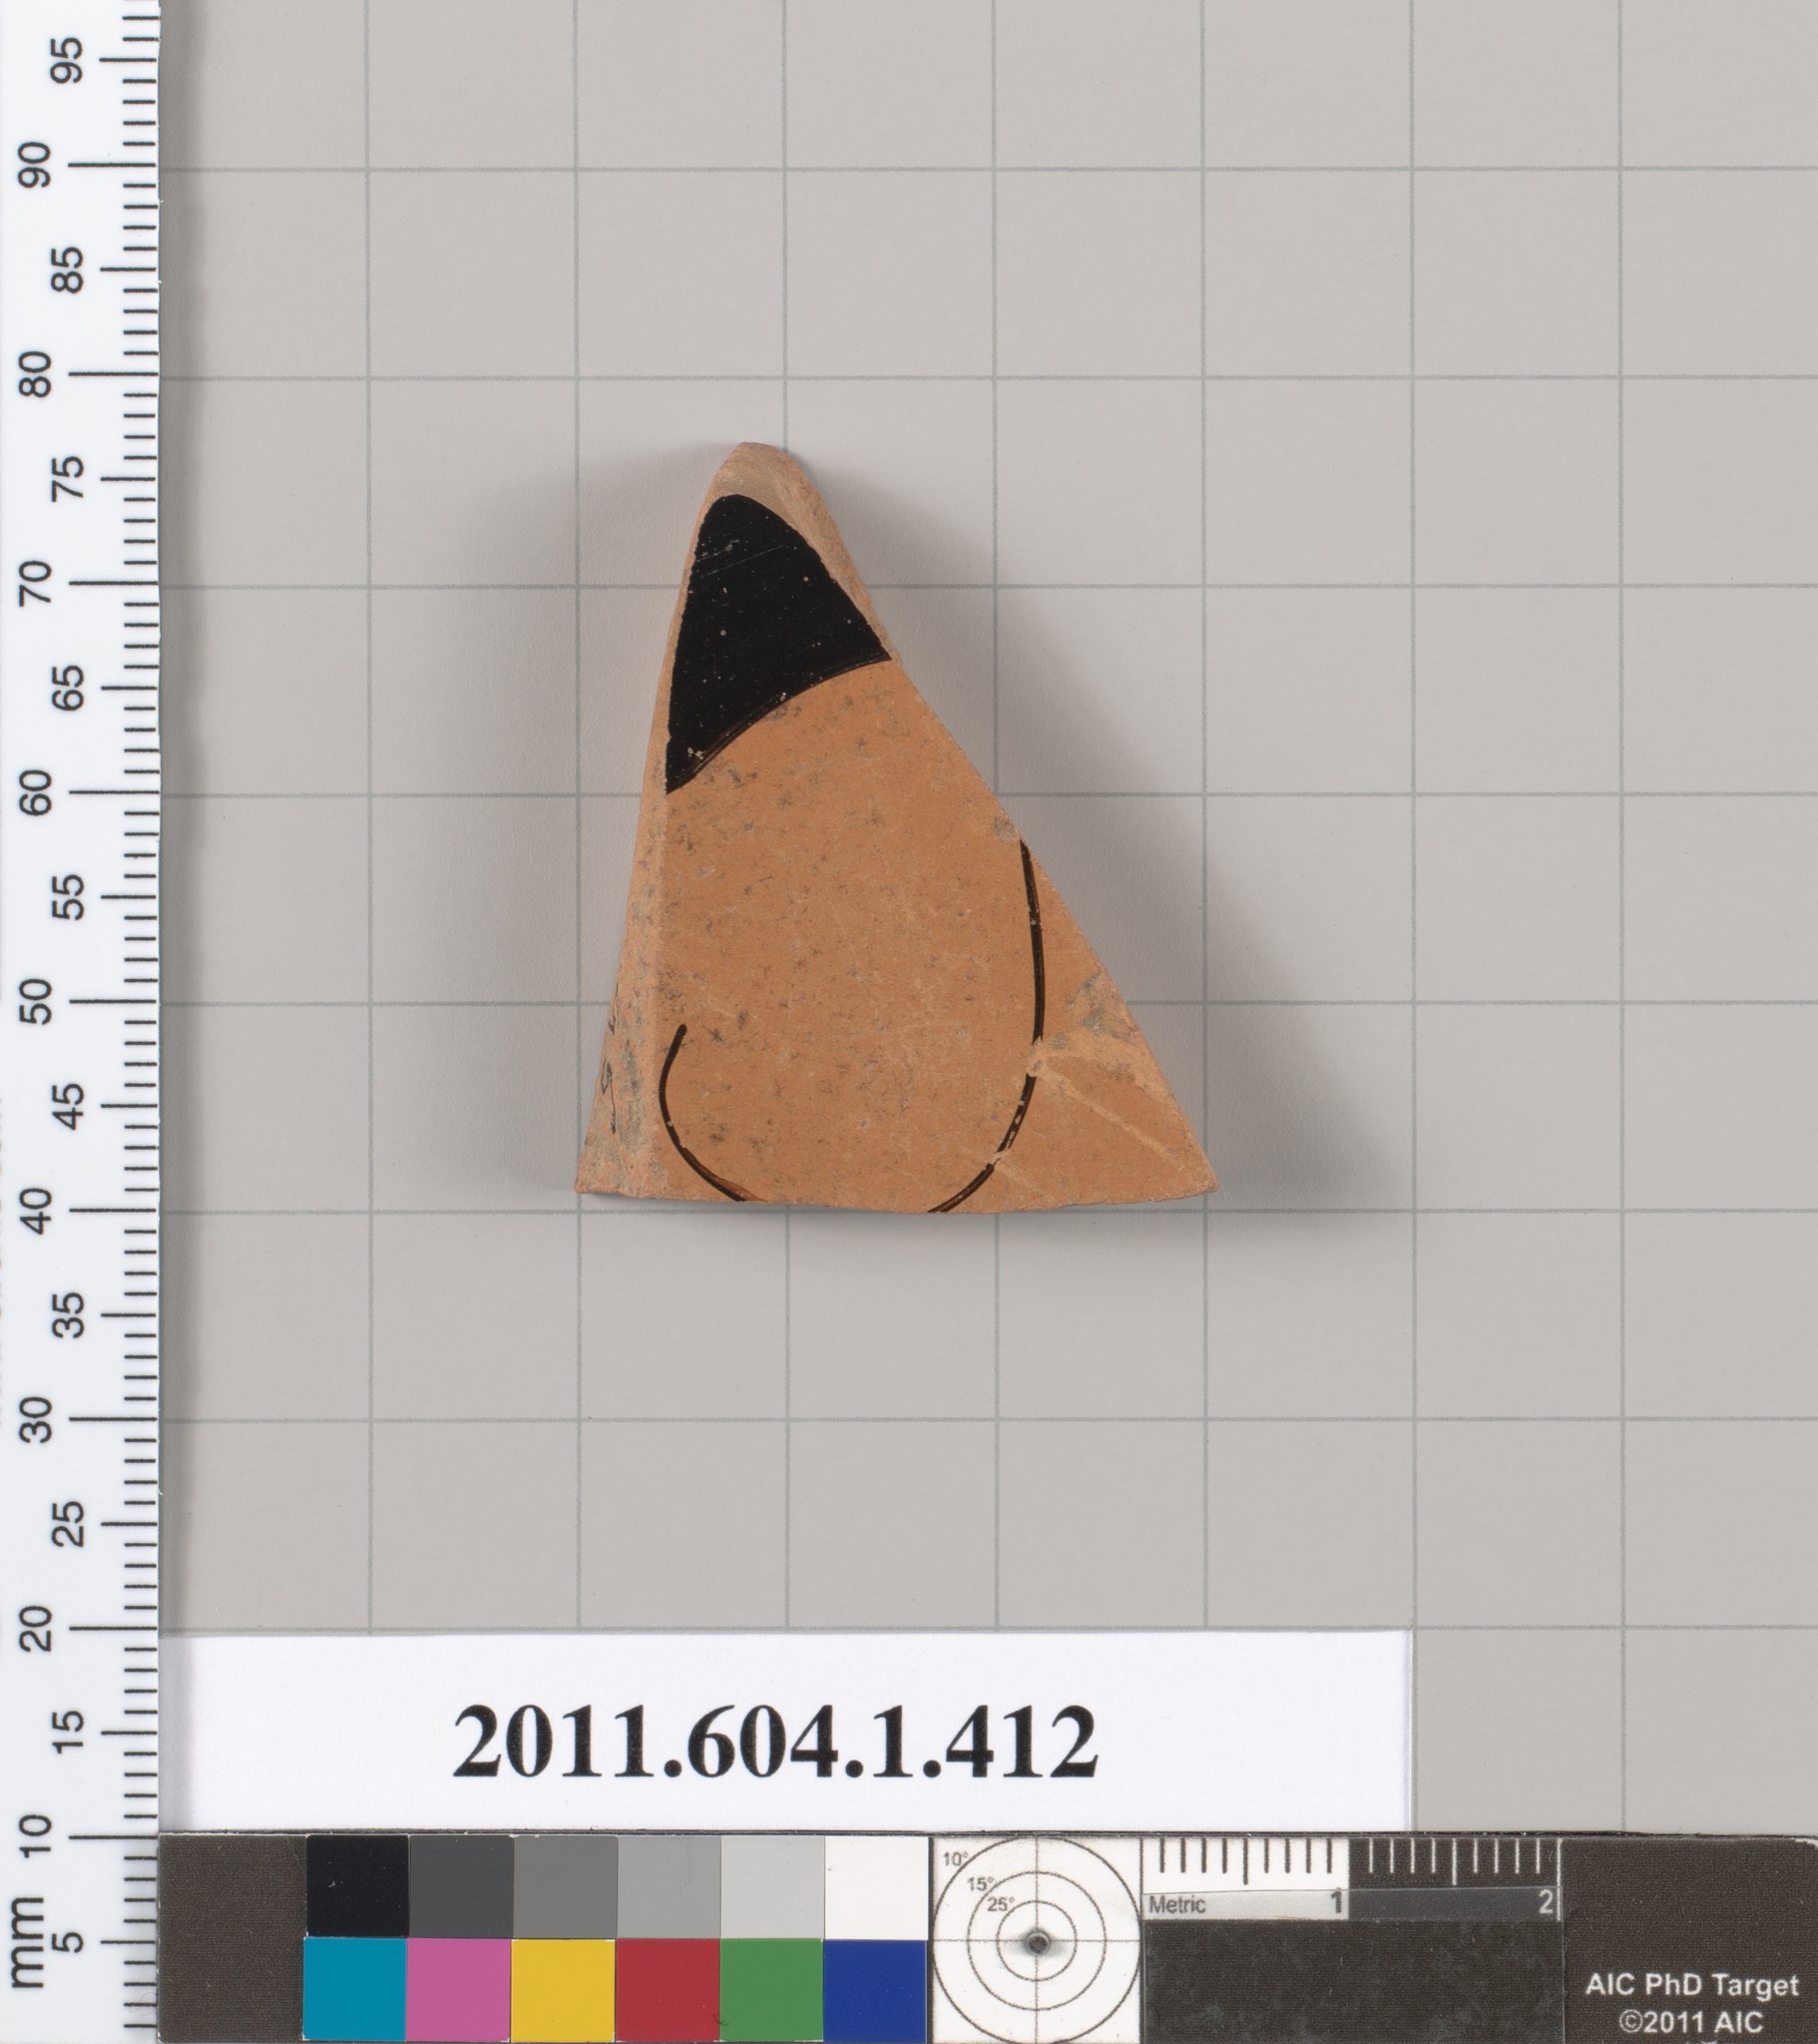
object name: kylix fragment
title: Terracotta fragment of a kylix (drinking cup)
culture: greek, attic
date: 475-451 BCE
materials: terracotta